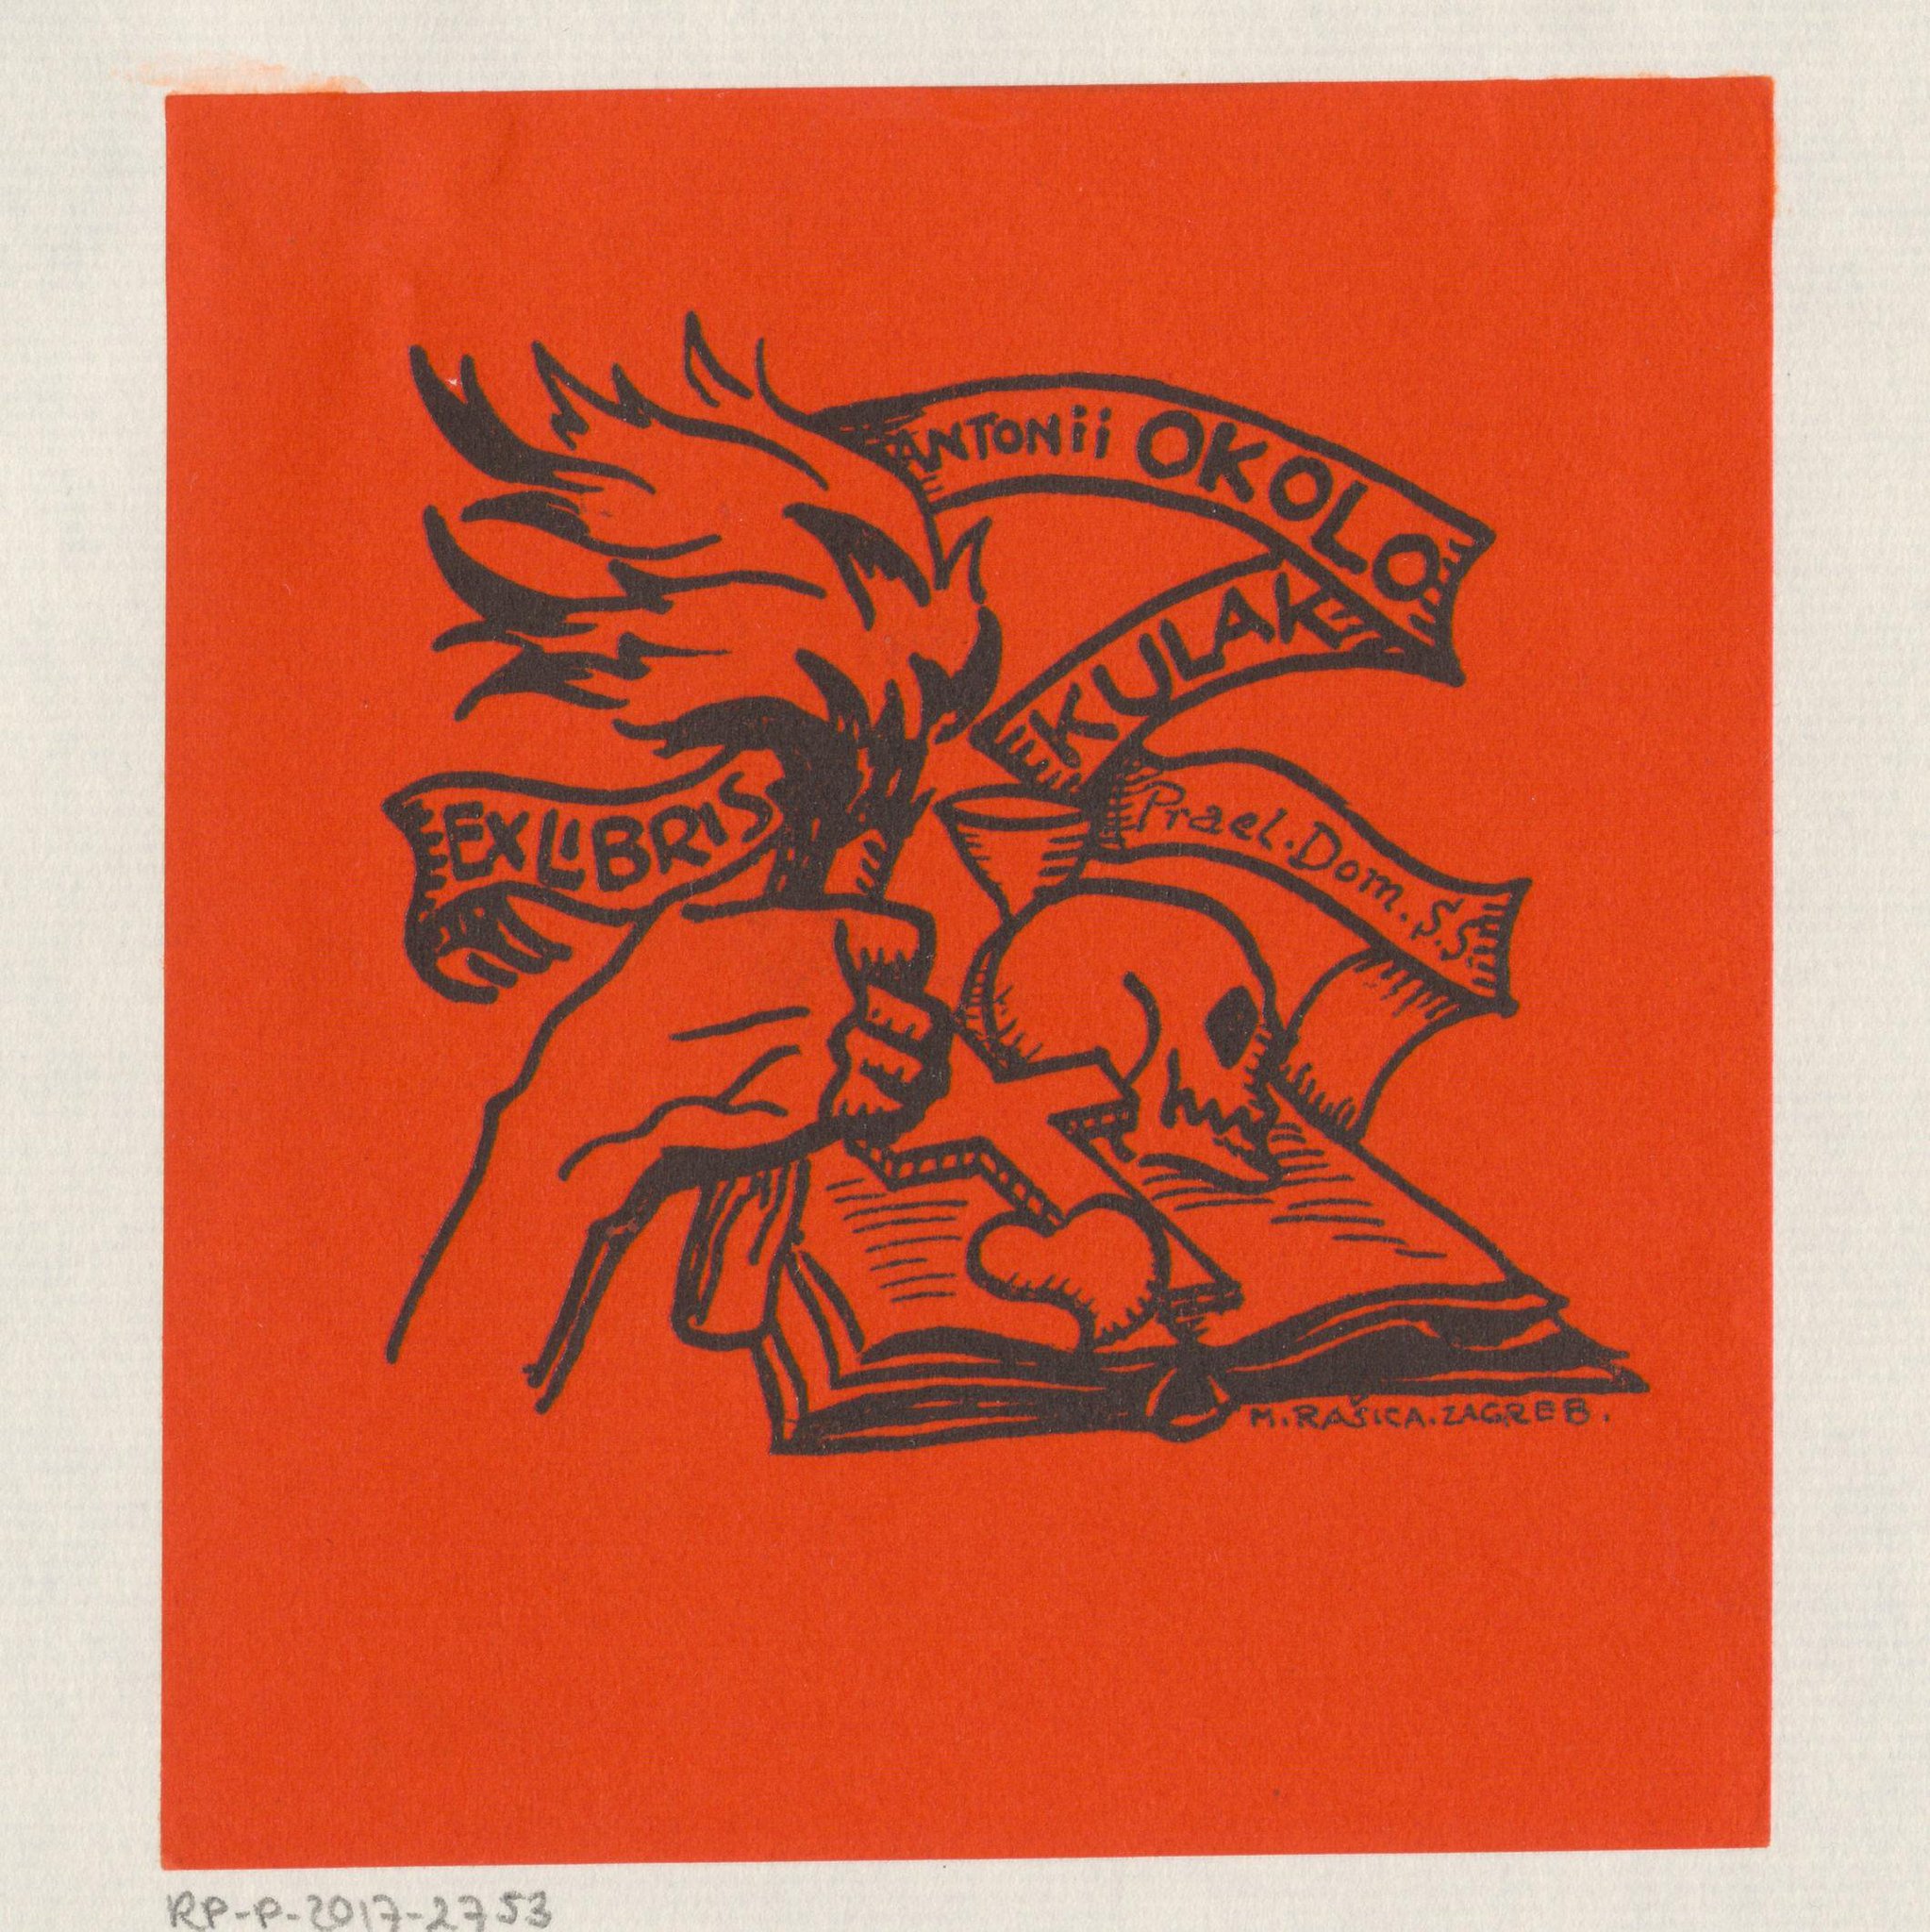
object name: bookplate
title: Ex libris Antonii Okolo Kulak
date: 1900-1940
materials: paper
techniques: printing block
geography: zagreb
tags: torch, cross as symbol of christ, (human) skull, book